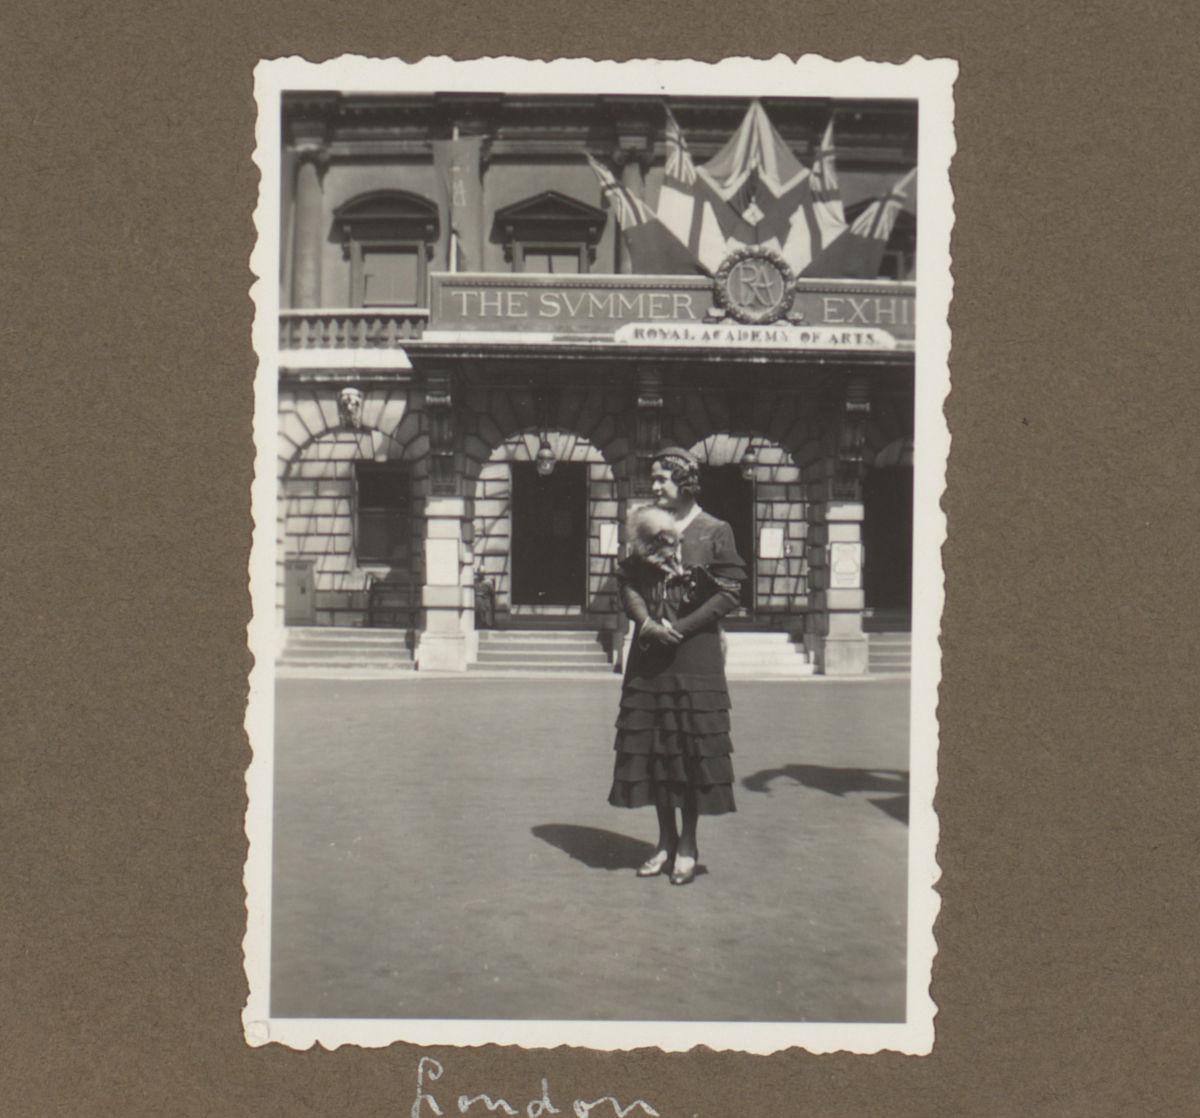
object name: album leaf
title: Portret van Wilhelmina van Zijll de Jong voor de Royal Academy of Arts, Londen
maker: Anonymous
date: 1906-1932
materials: paper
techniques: gelatin silver print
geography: london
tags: wilhelmina van zijll de jong, historical persons - bb - woman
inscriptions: inscription: ‘London’